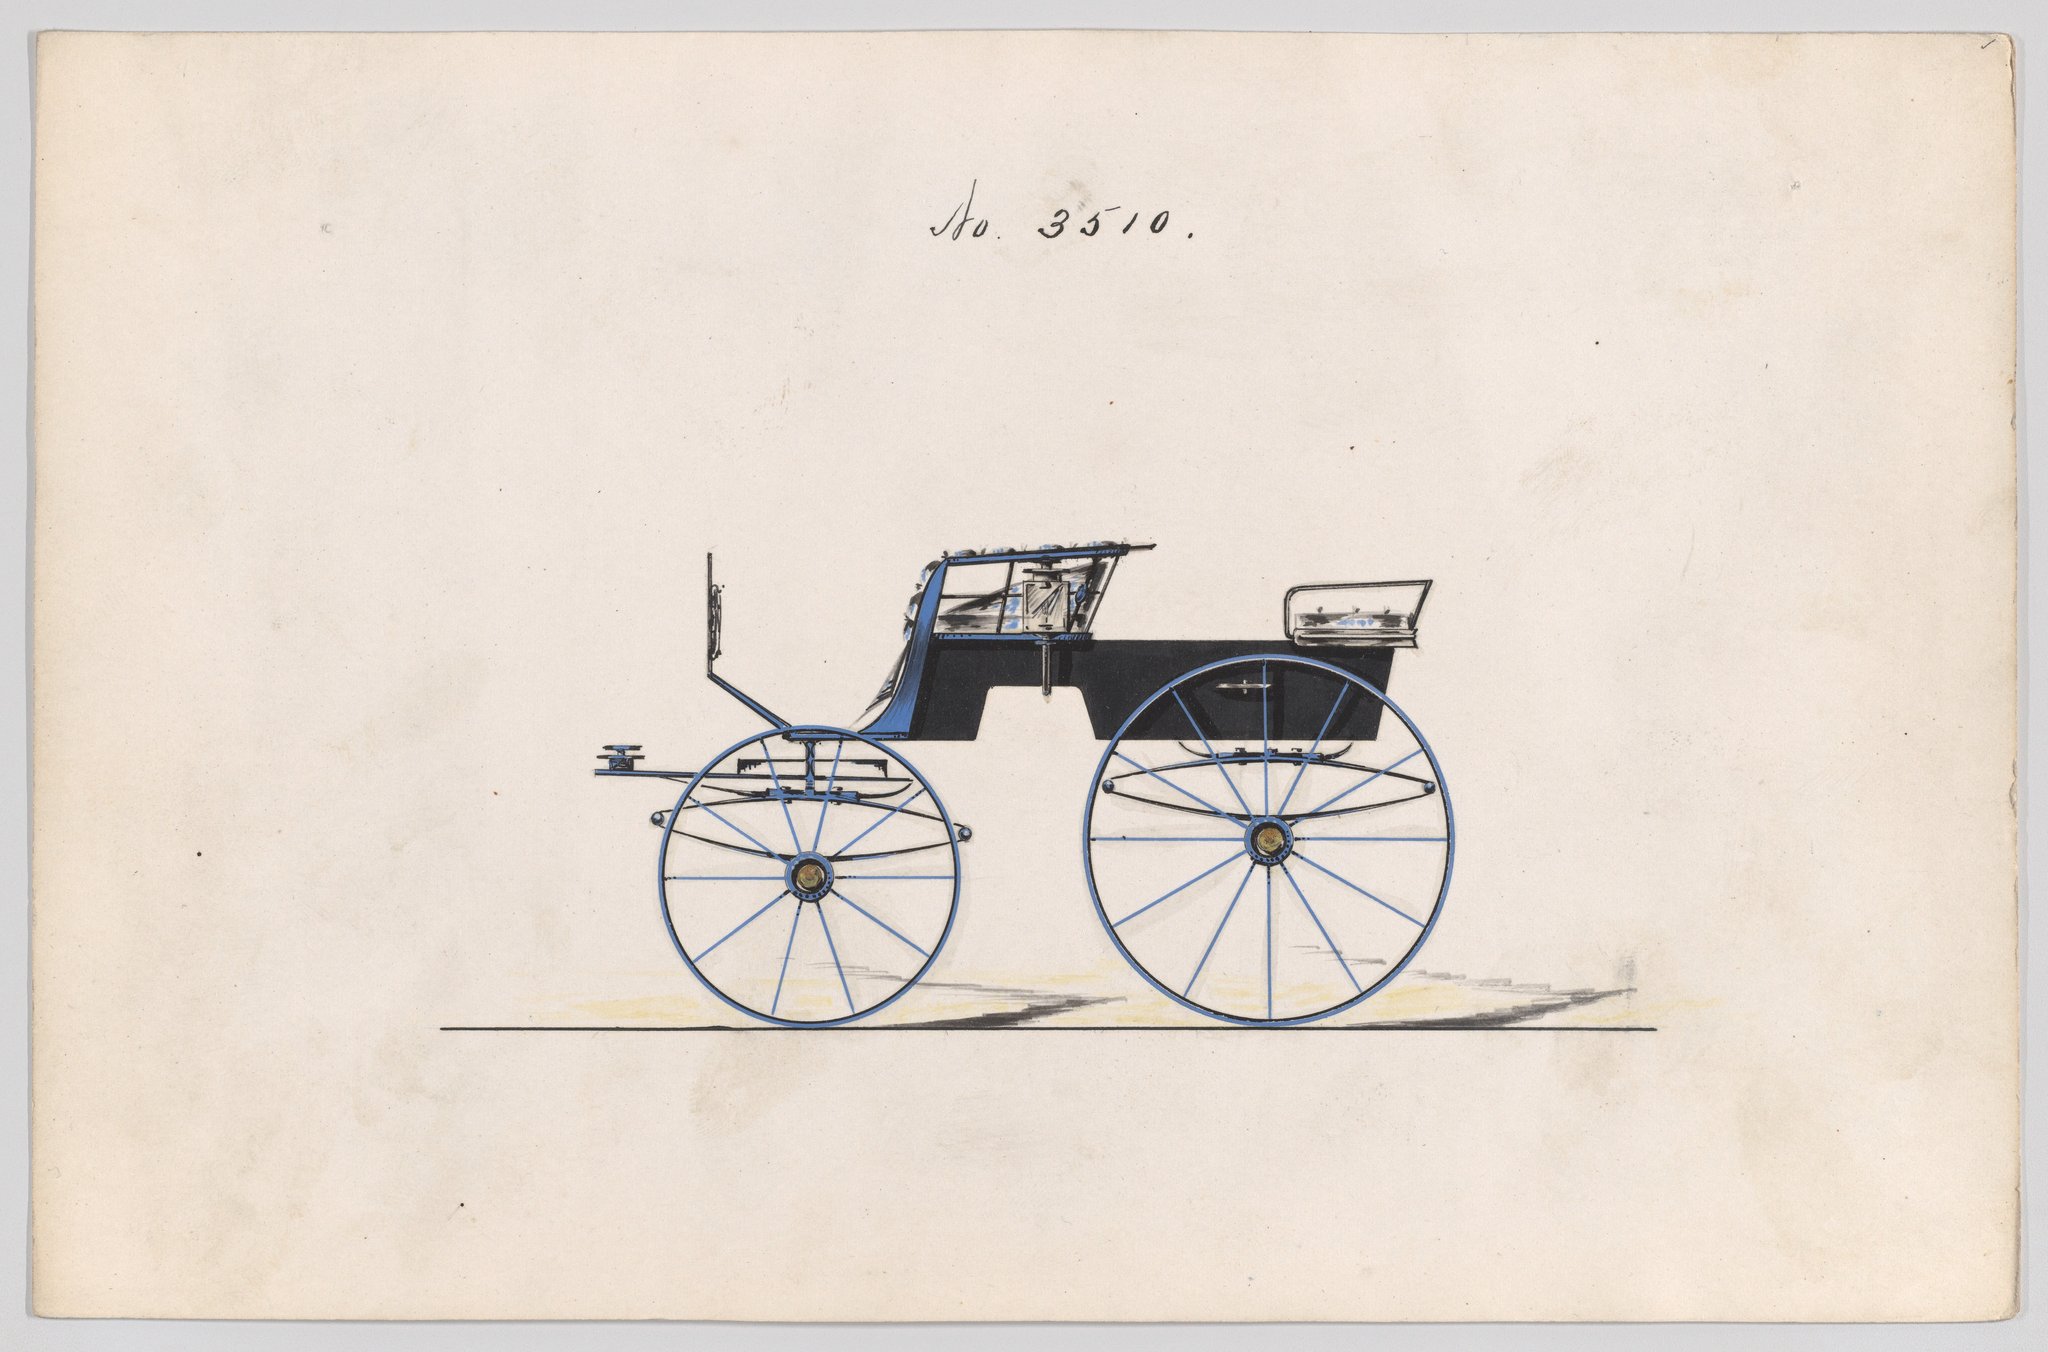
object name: drawing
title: Design for T-Cart, no. 3510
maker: brewster & co.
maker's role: manufacturer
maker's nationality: american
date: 1879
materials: gouache, gum arabic, ink, watercolor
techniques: pen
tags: carriages